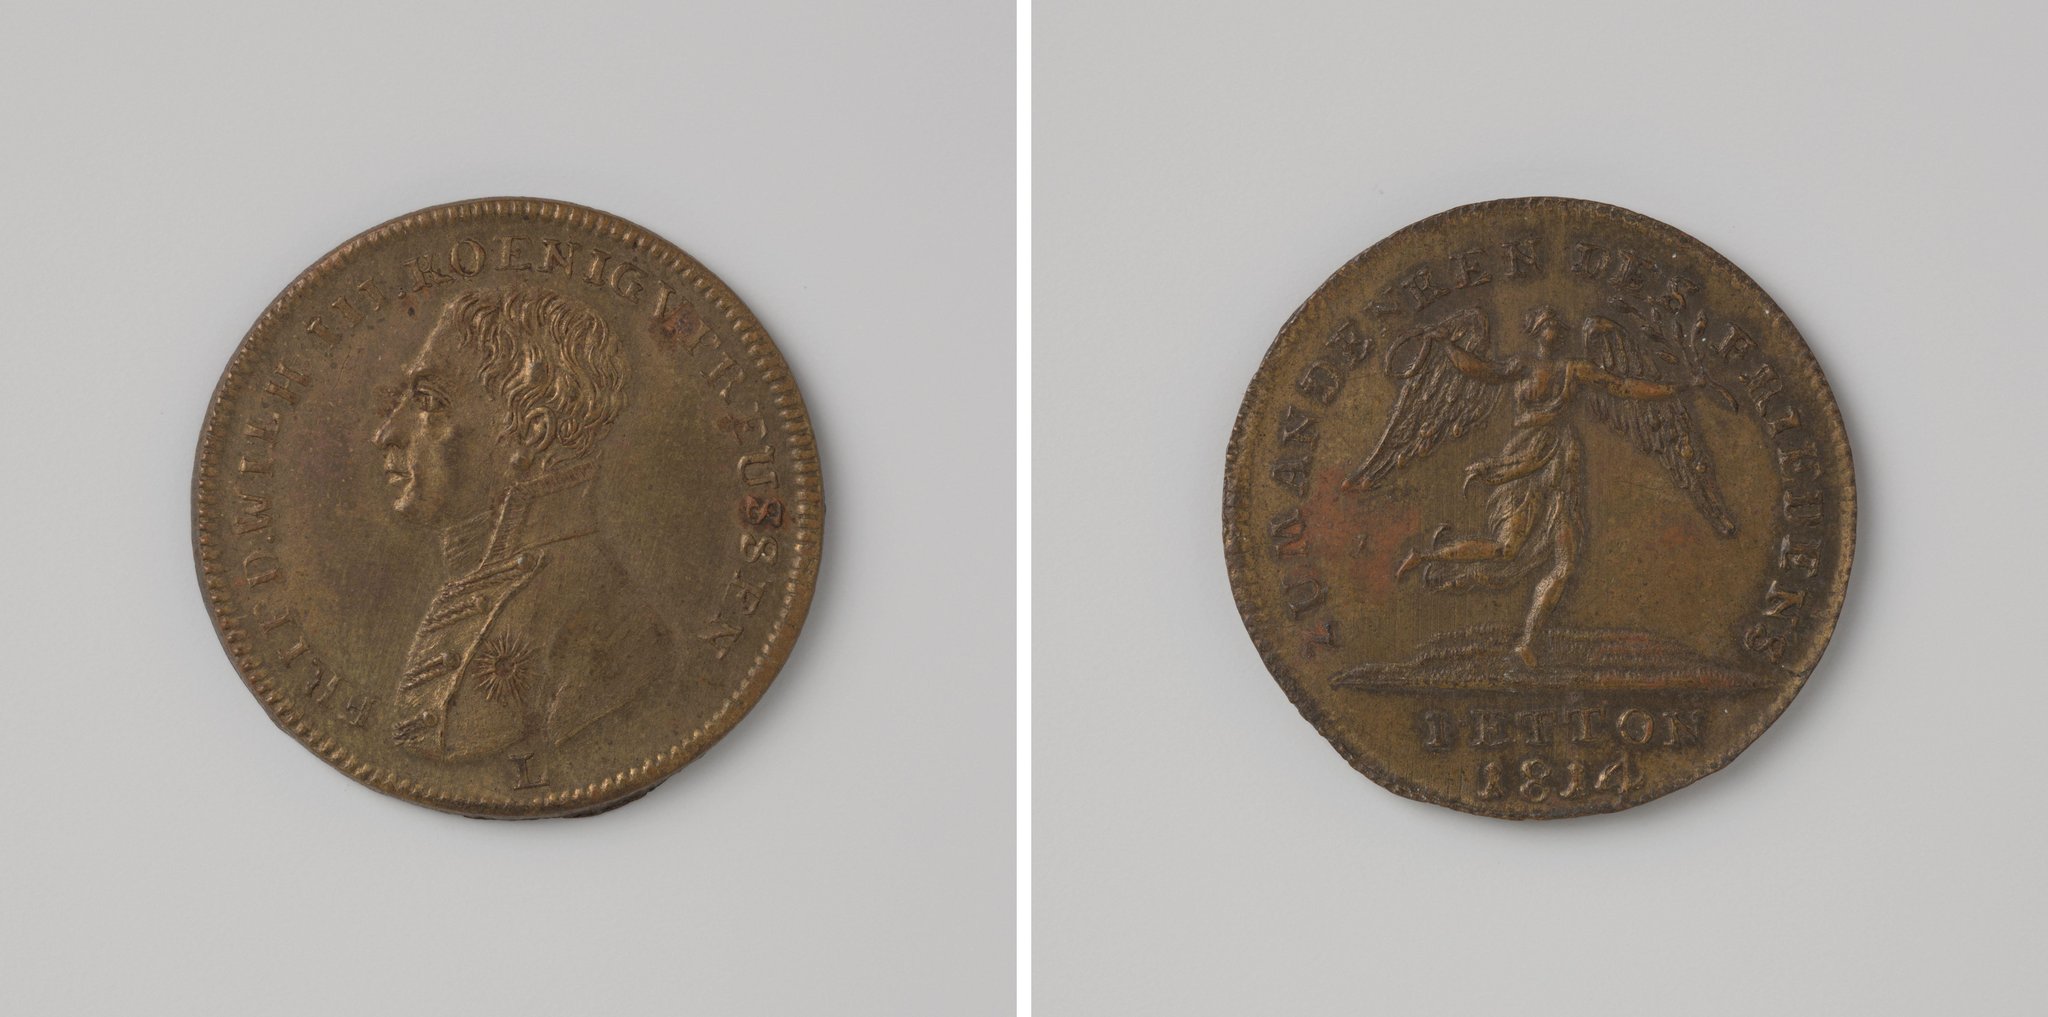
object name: jeton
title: Eerste vrede van Parijs tussen Frankrijk en de geallieerden, ter ere van Frederik Willem III, koning van Pruisen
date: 1814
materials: copper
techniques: striking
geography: nuremberg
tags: berlin, frederik willem iii koning van pruisen, paris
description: Koperen penning. Voorzijde: borststuk man binnen omschrift. Keerzijde: gevleugelde Vrede met lauwerkrans en olijftak binnen omschrift; afsnede: opschrift